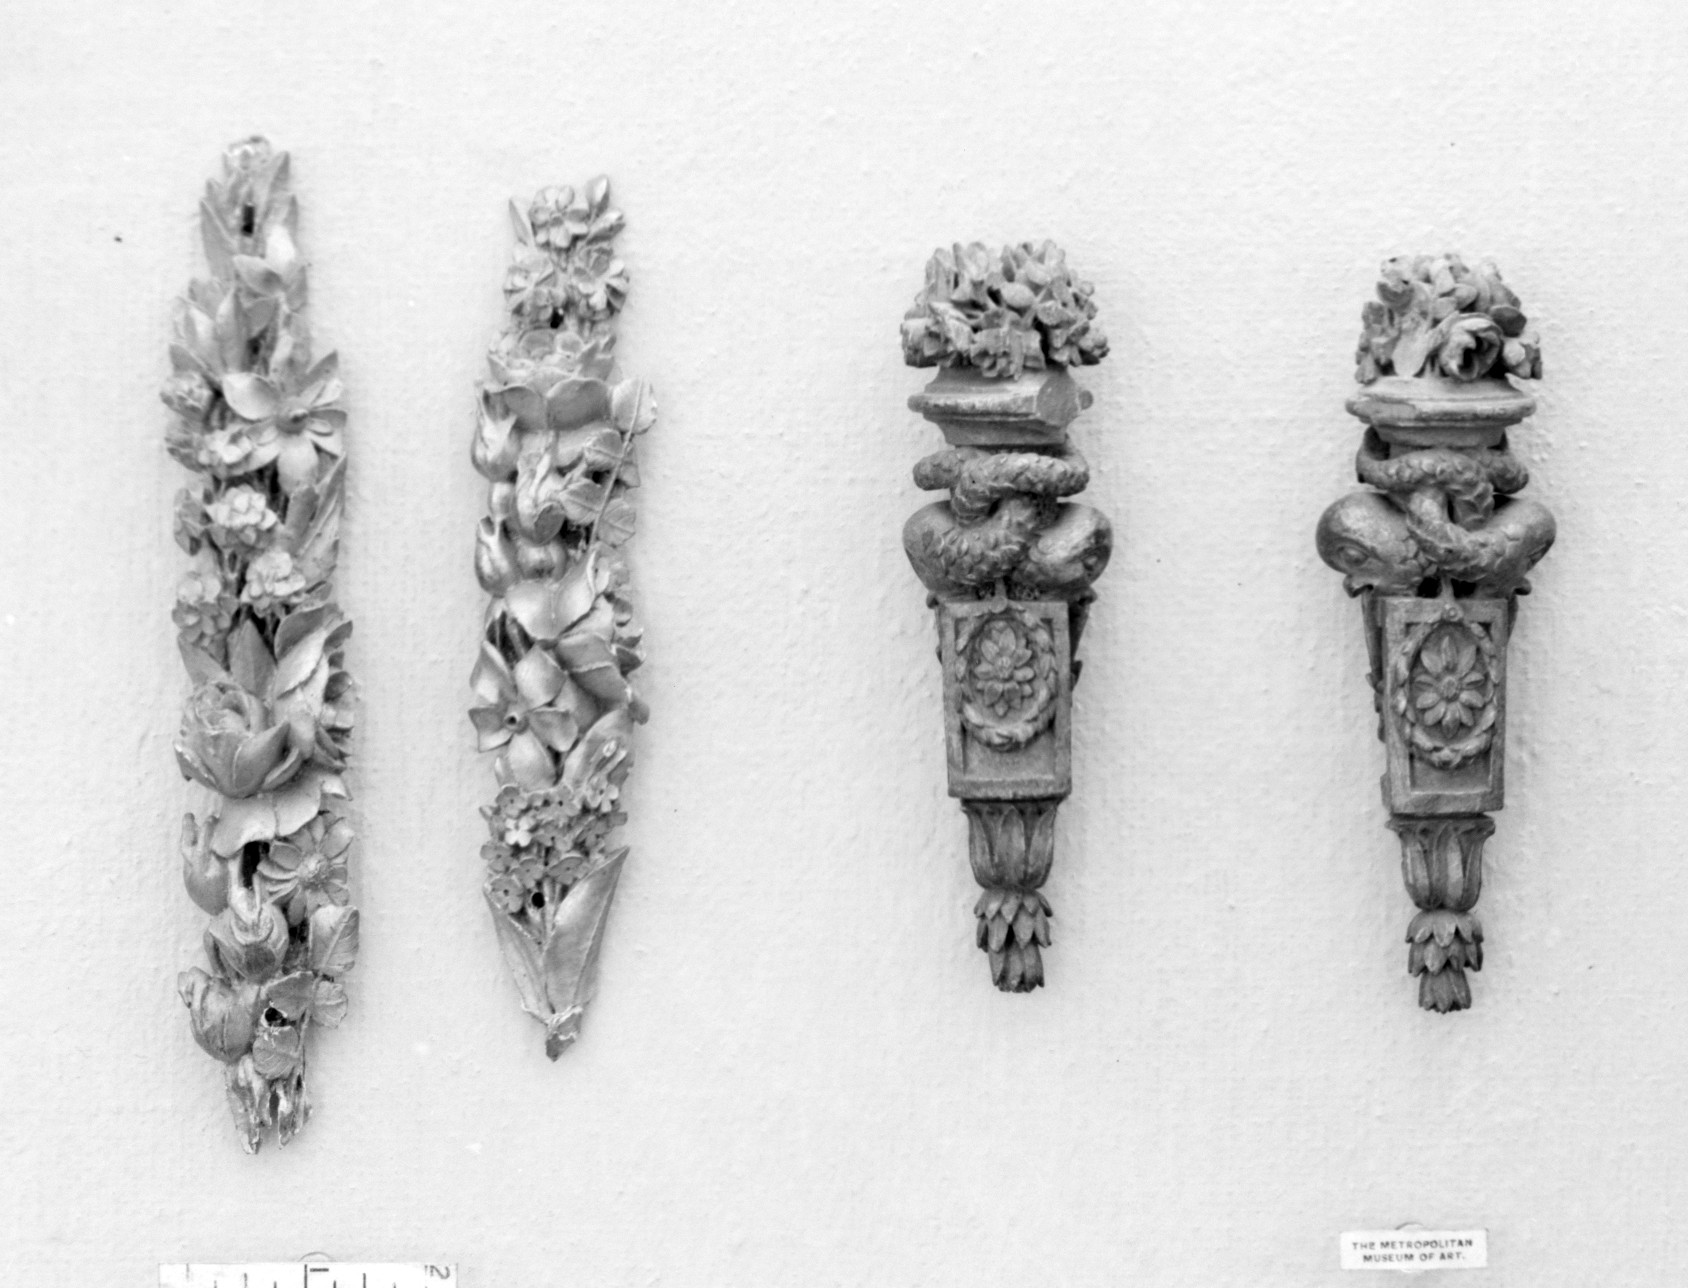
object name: wall vase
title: Pair of wall vases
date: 1701-1800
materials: wood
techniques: gilding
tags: animals,flowers